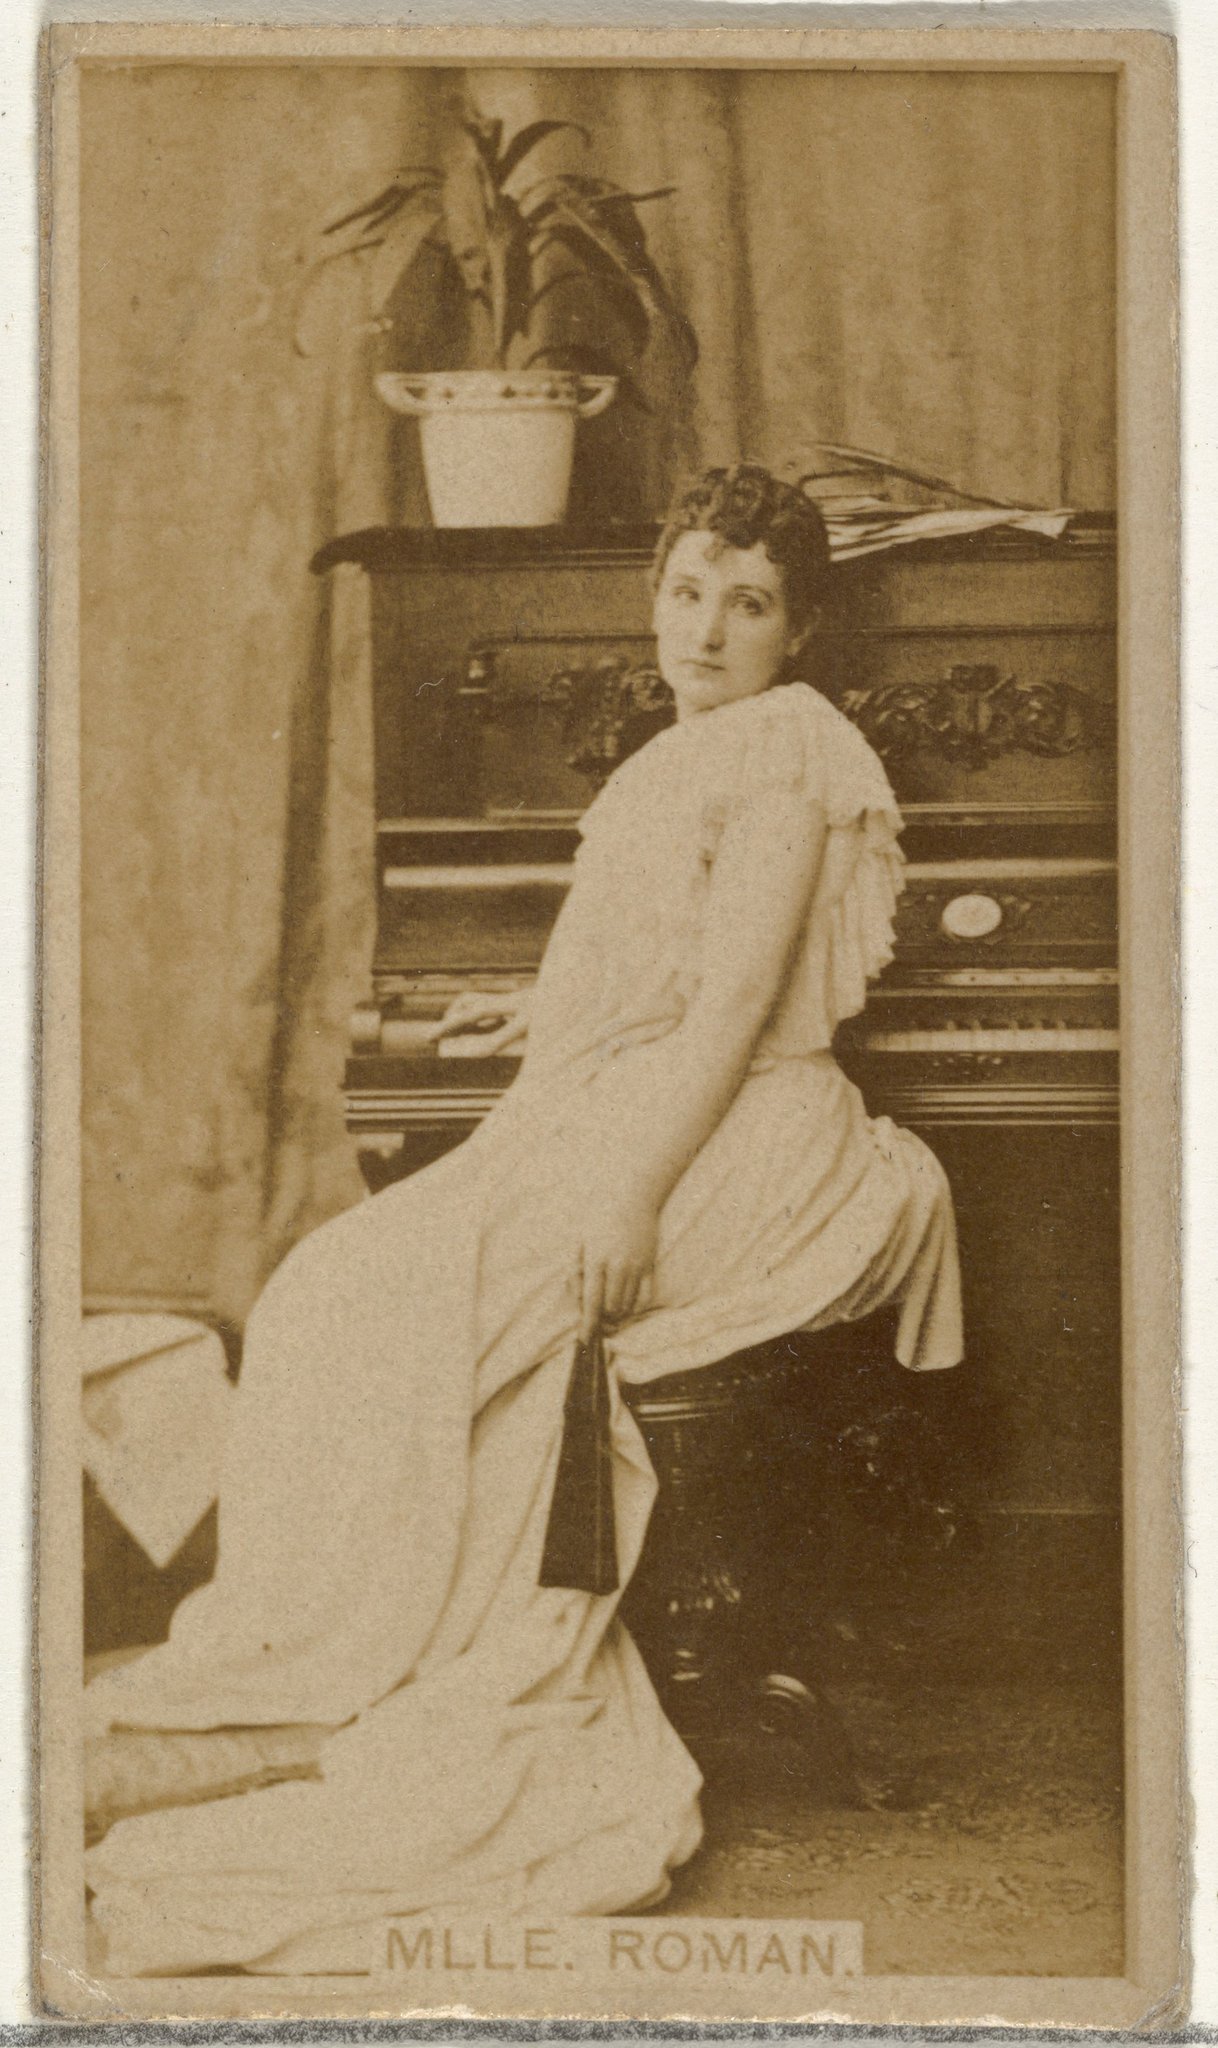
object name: photograph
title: Mlle. Roman, from the Actors and Actresses series (N145-8) issued by Duke Sons & Co. to promote Duke Cigarettes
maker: w. duke, sons & co.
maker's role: publisher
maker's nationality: american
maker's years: 1870-1920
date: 1891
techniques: albumen silver print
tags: portraits,women,actresses